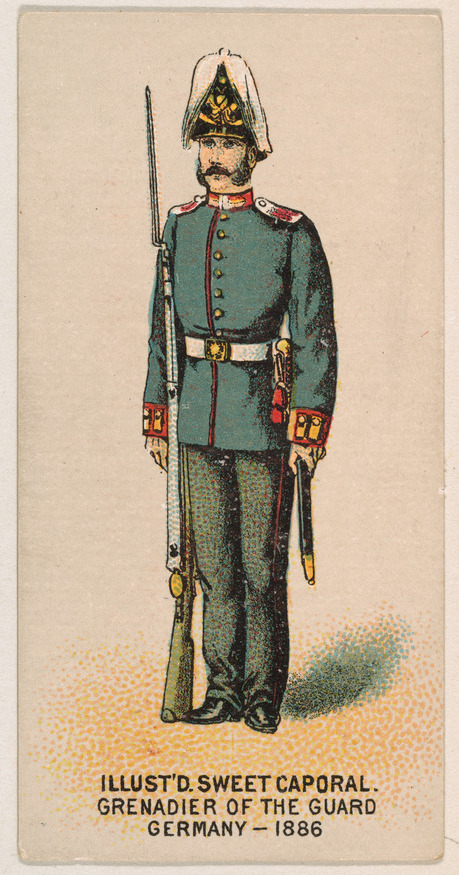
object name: print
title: Grenadier of the Guard, Germany, 1886, from the Military Series (N224) issued by Kinney Tobacco Company to promote Sweet Caporal Cigarettes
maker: kinney brothers tobacco company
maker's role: publisher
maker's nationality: american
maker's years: 1869-2011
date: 1888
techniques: color lithograph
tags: soldiers,firearms,men